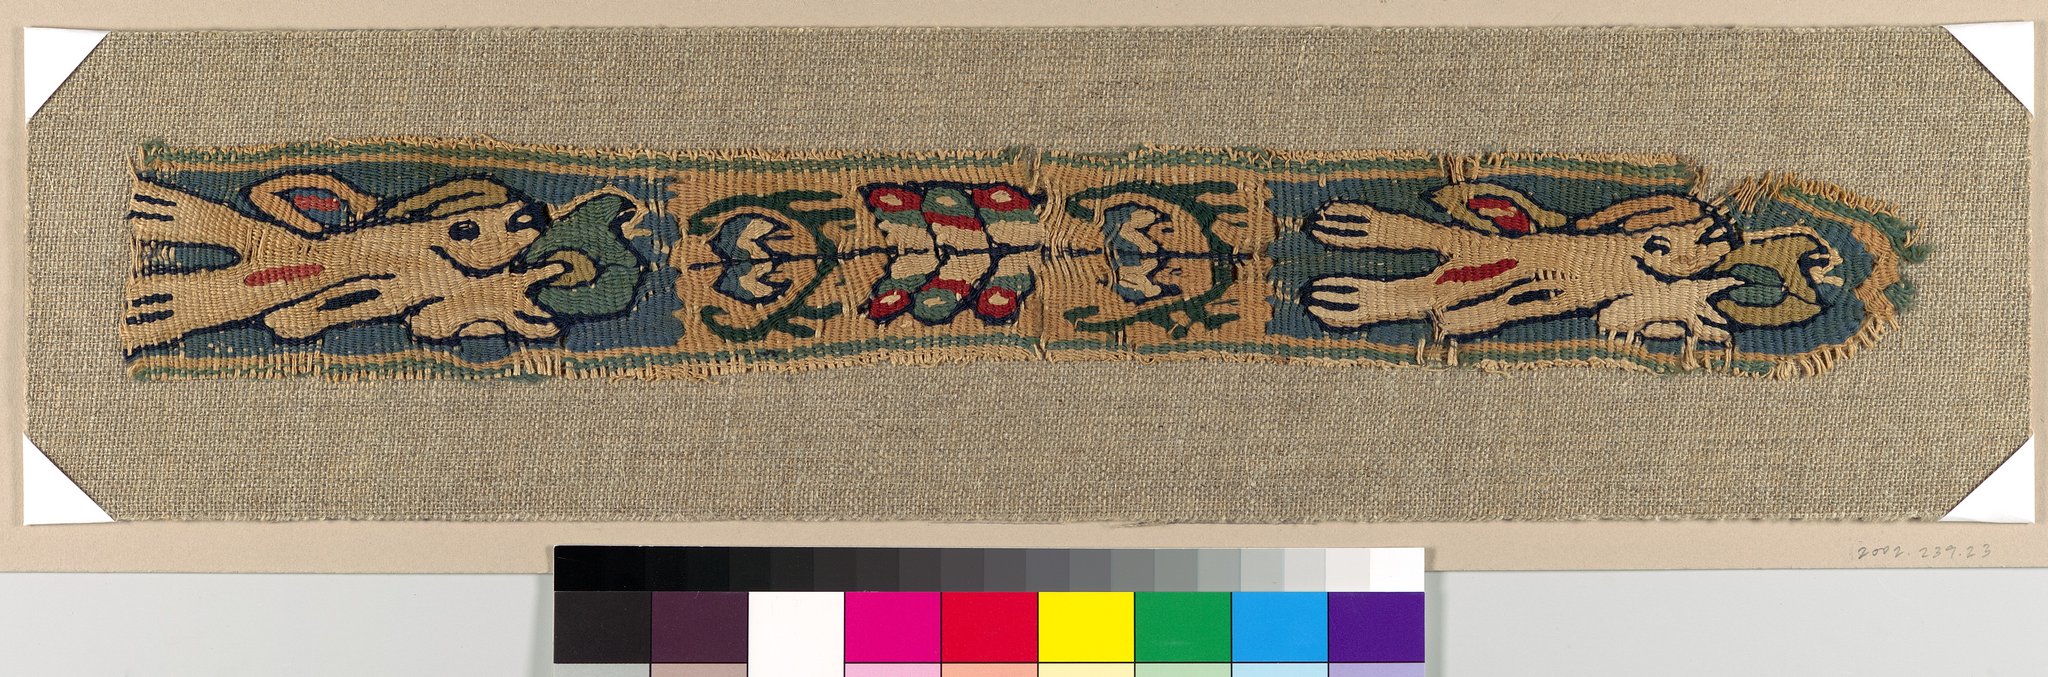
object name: textile fragment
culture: byzantine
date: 701-1000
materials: linen, wool